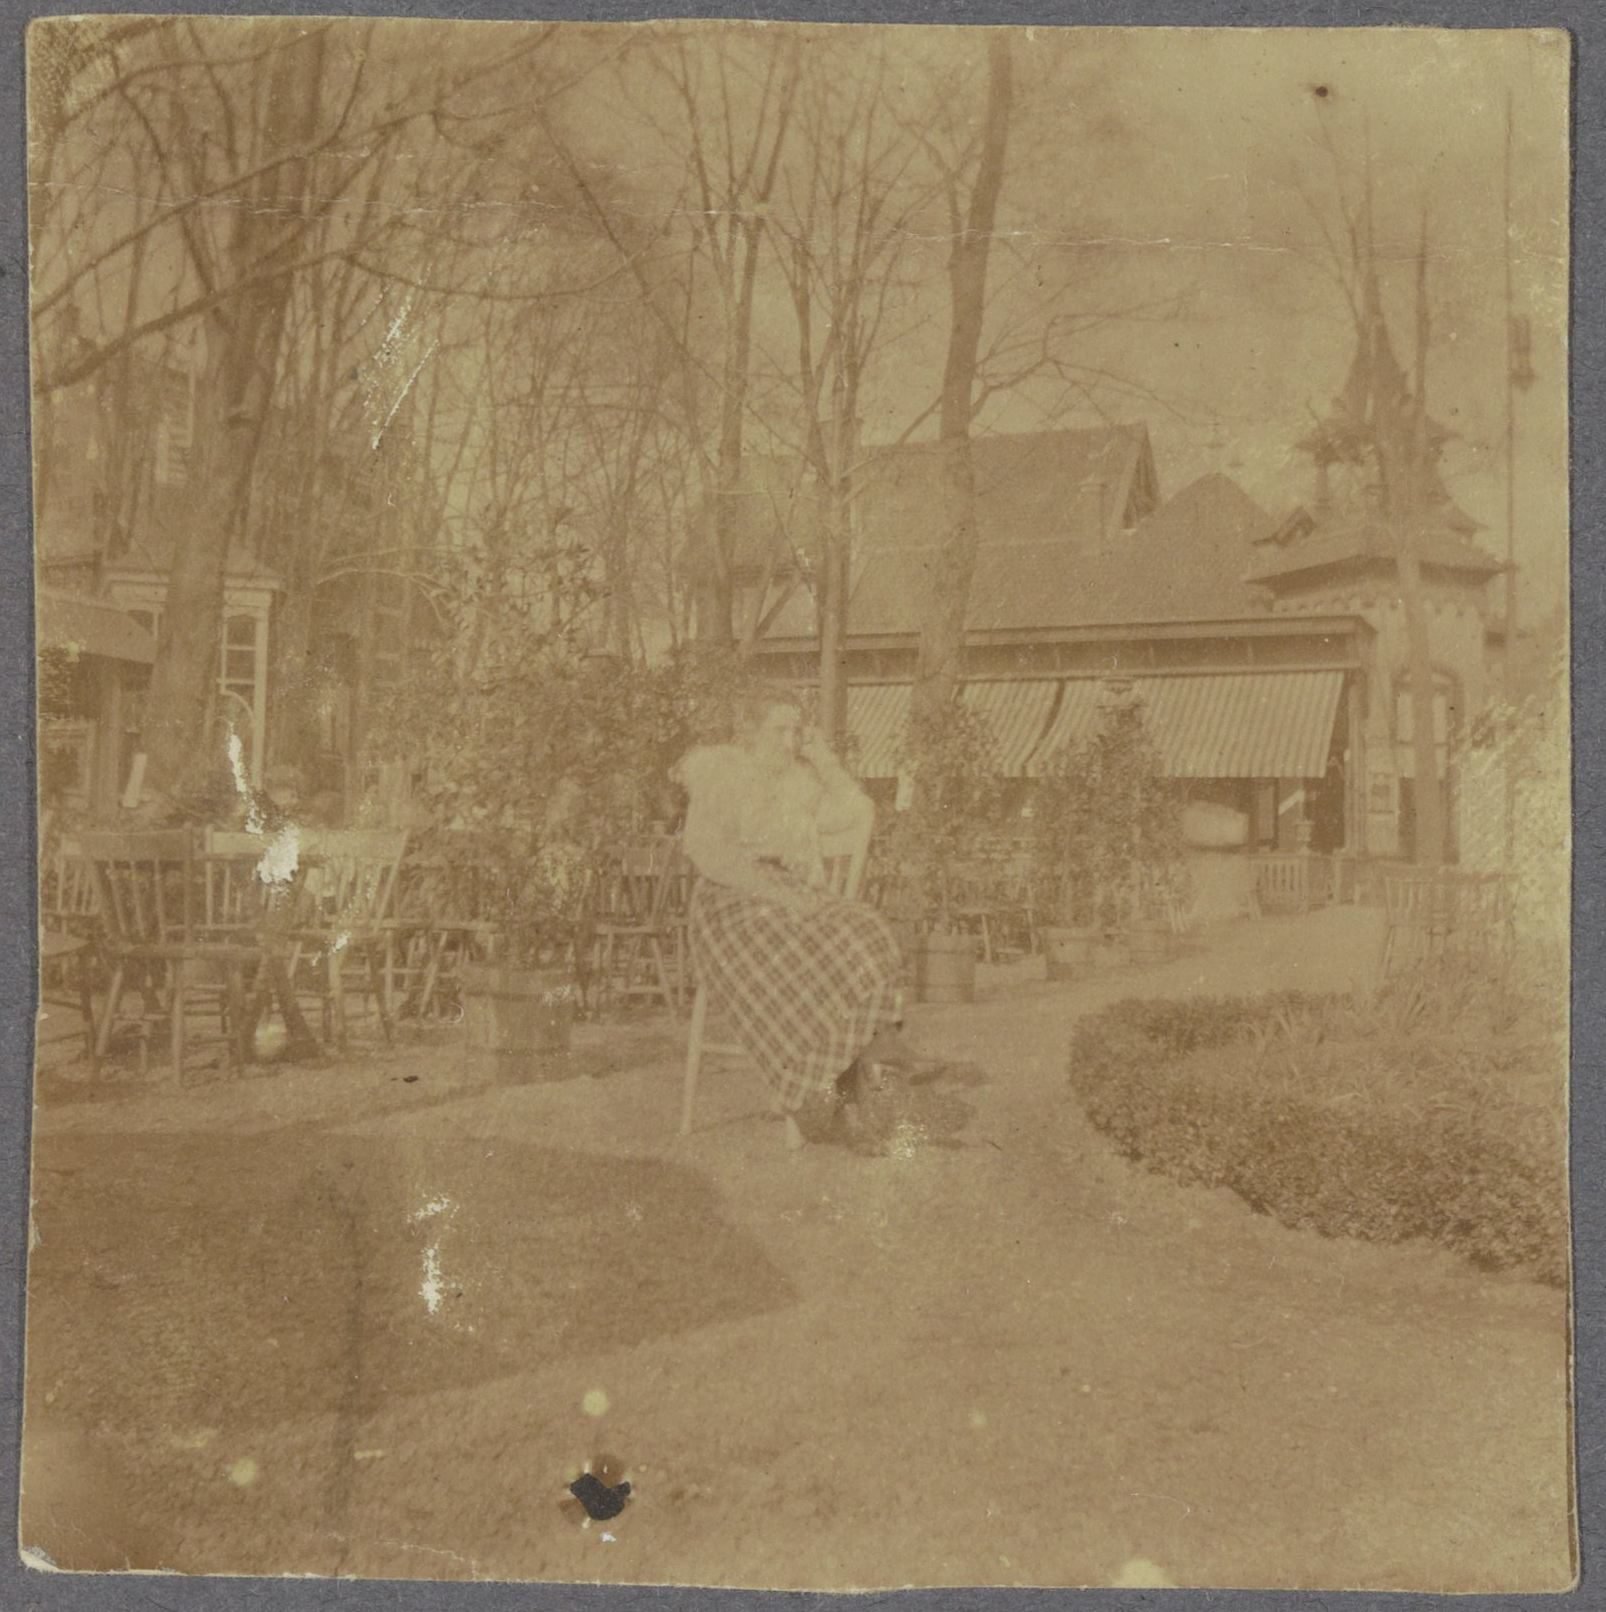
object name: album leaf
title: Portret van een vrouw in een geruite rok op een terras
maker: Anonymous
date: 1920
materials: cardboard, paper, photographic support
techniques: daylight paper print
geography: netherlands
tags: adult woman, historical persons, skirt, terrace, netherlands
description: Onderdeel van Fotoalbum met portretten vervaardigd door Nederlandse studio's waaronder automaatfoto's.